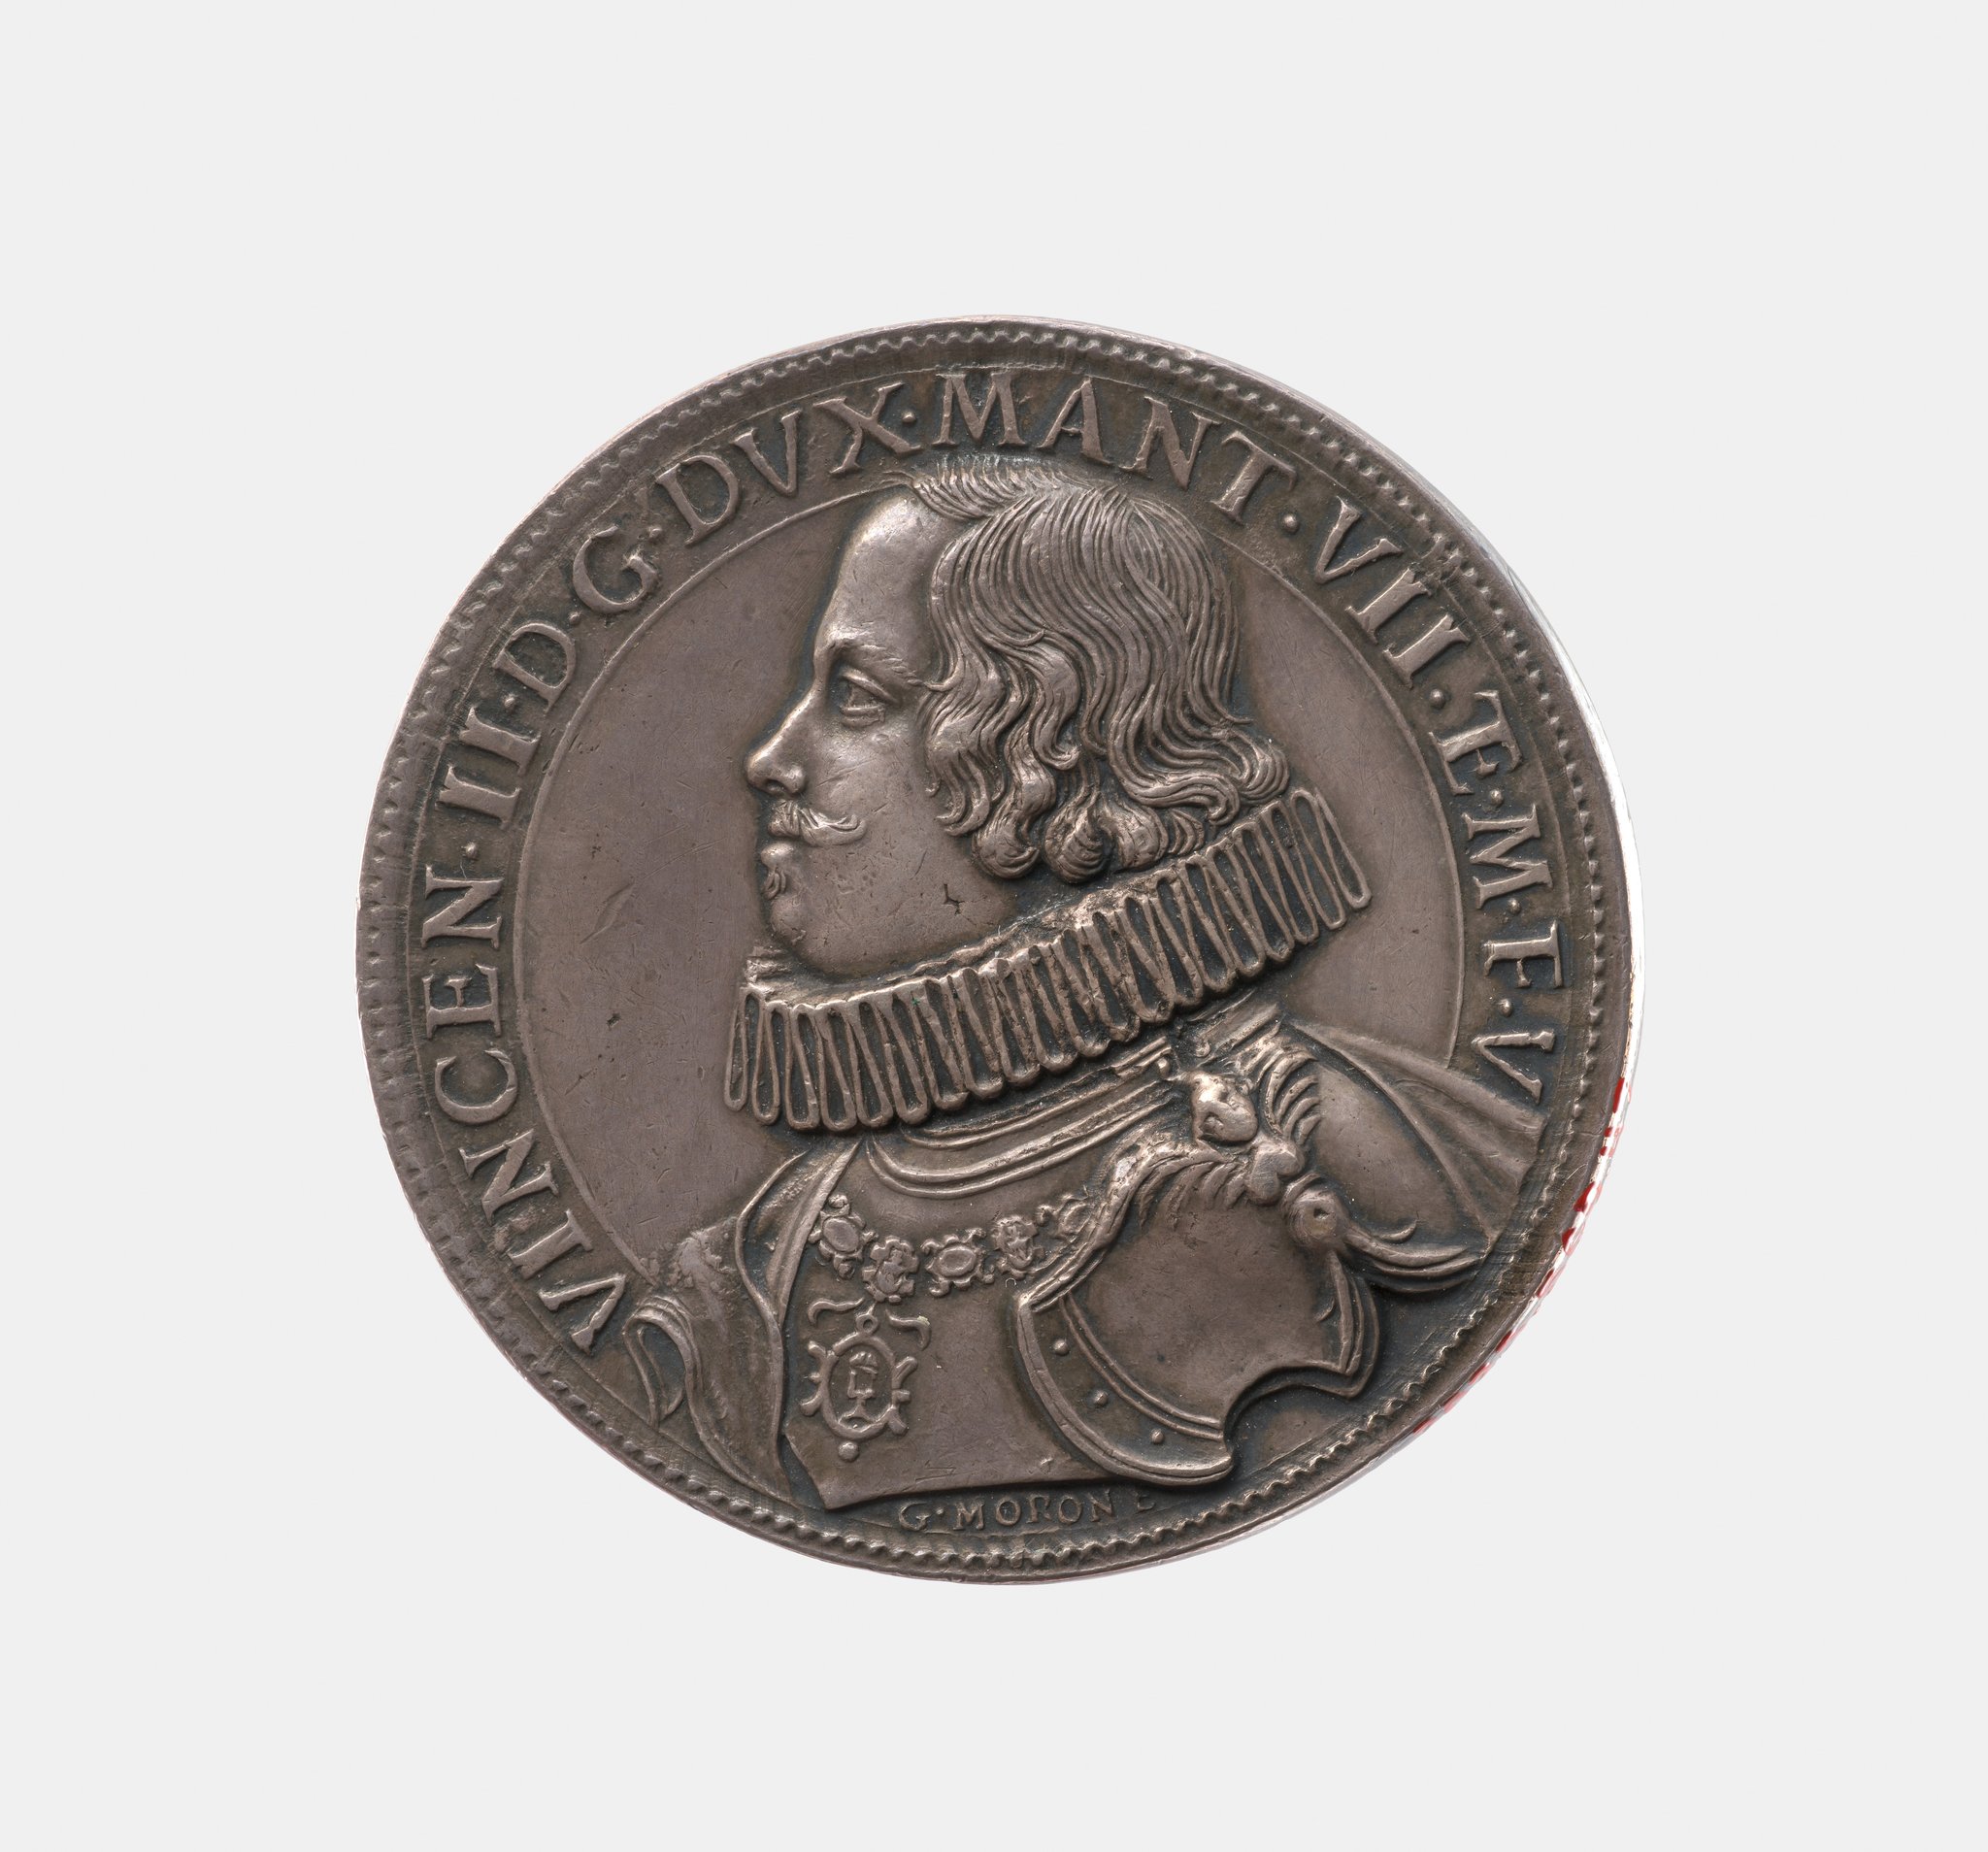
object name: medal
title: Vincenzo II Gonzaga, Duke of Mantua 1626-27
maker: gasparo morone-mola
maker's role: artist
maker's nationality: italian, rome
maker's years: 1627-1668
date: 1627-1640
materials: silver